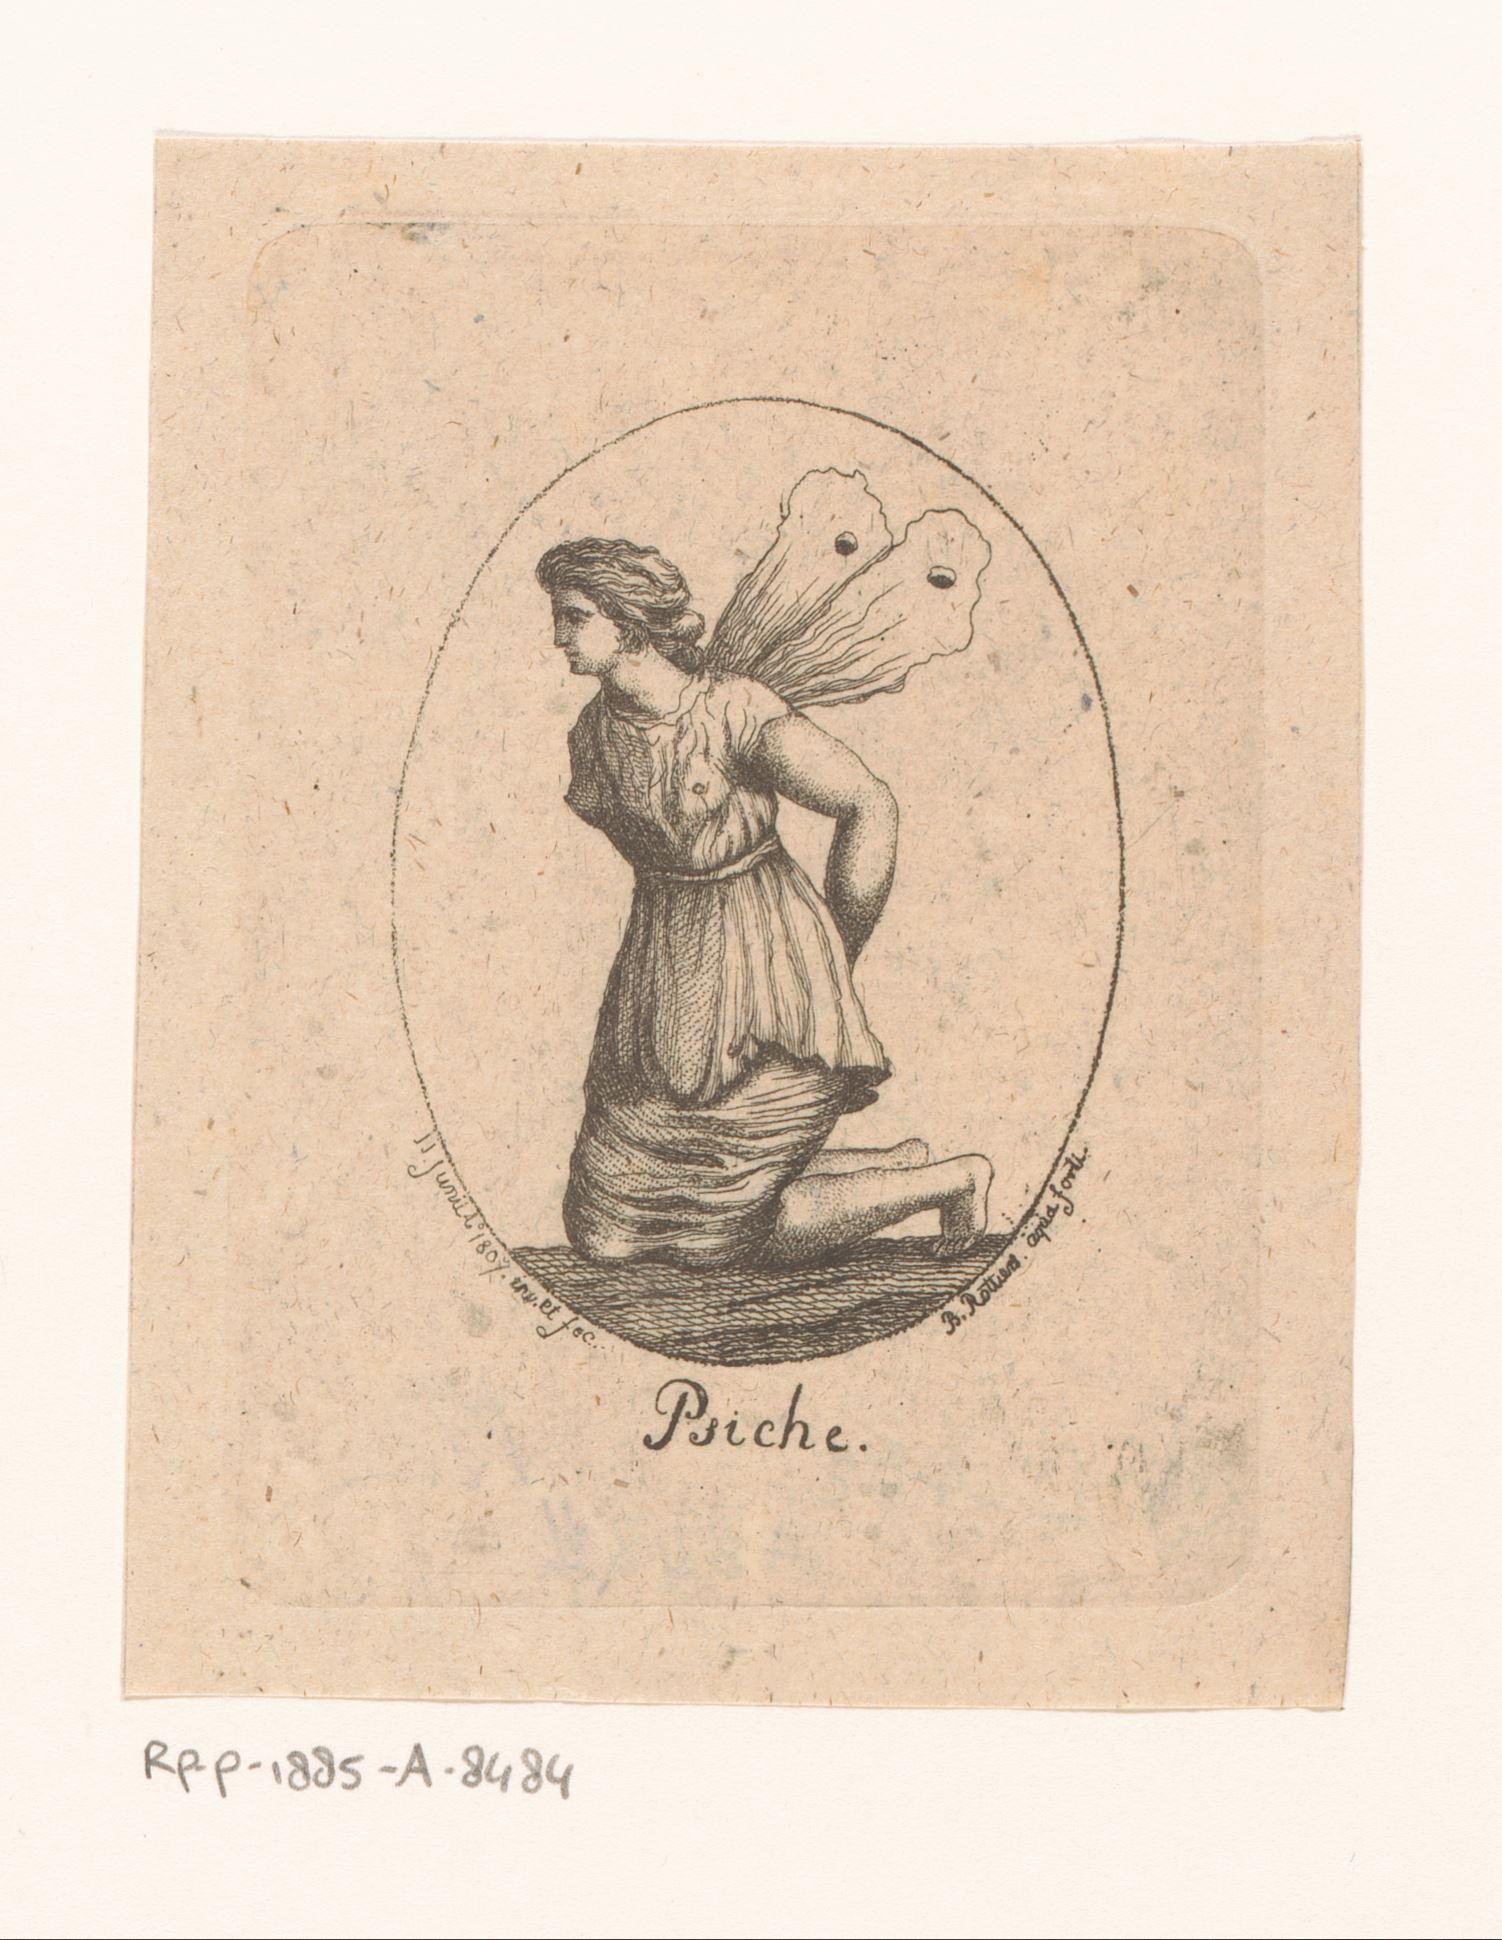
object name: print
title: Psyche op haar knieën met handen op de rug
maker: bernard eugène antoine rottiers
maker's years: 1771-1857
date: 1807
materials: paper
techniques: etching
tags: psyche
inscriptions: collector's mark: Lugt 2228